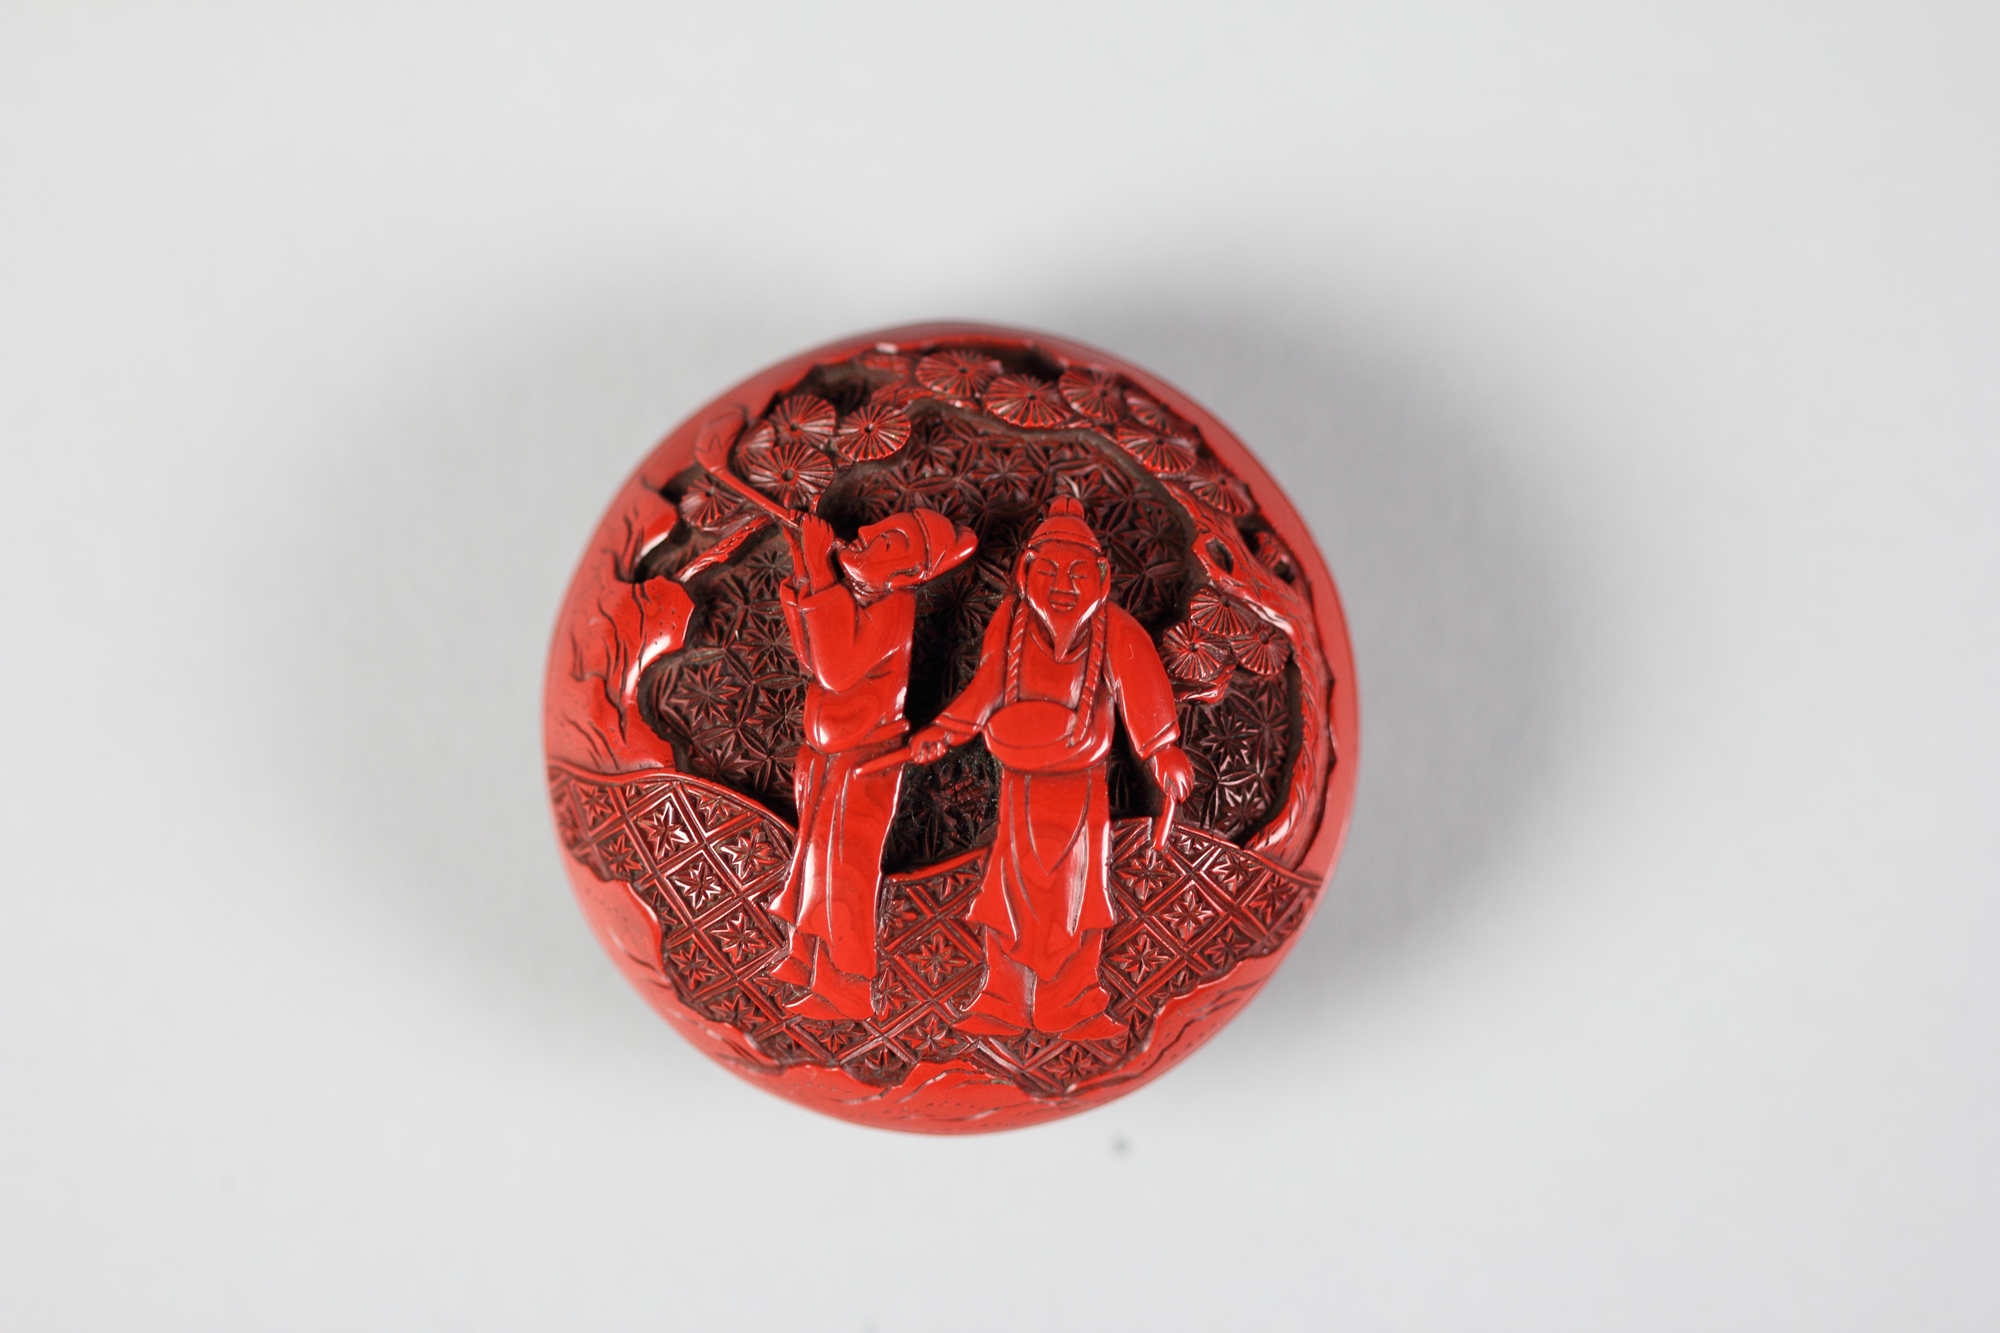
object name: netsuke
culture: japanese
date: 1701-1800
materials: lacquer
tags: men